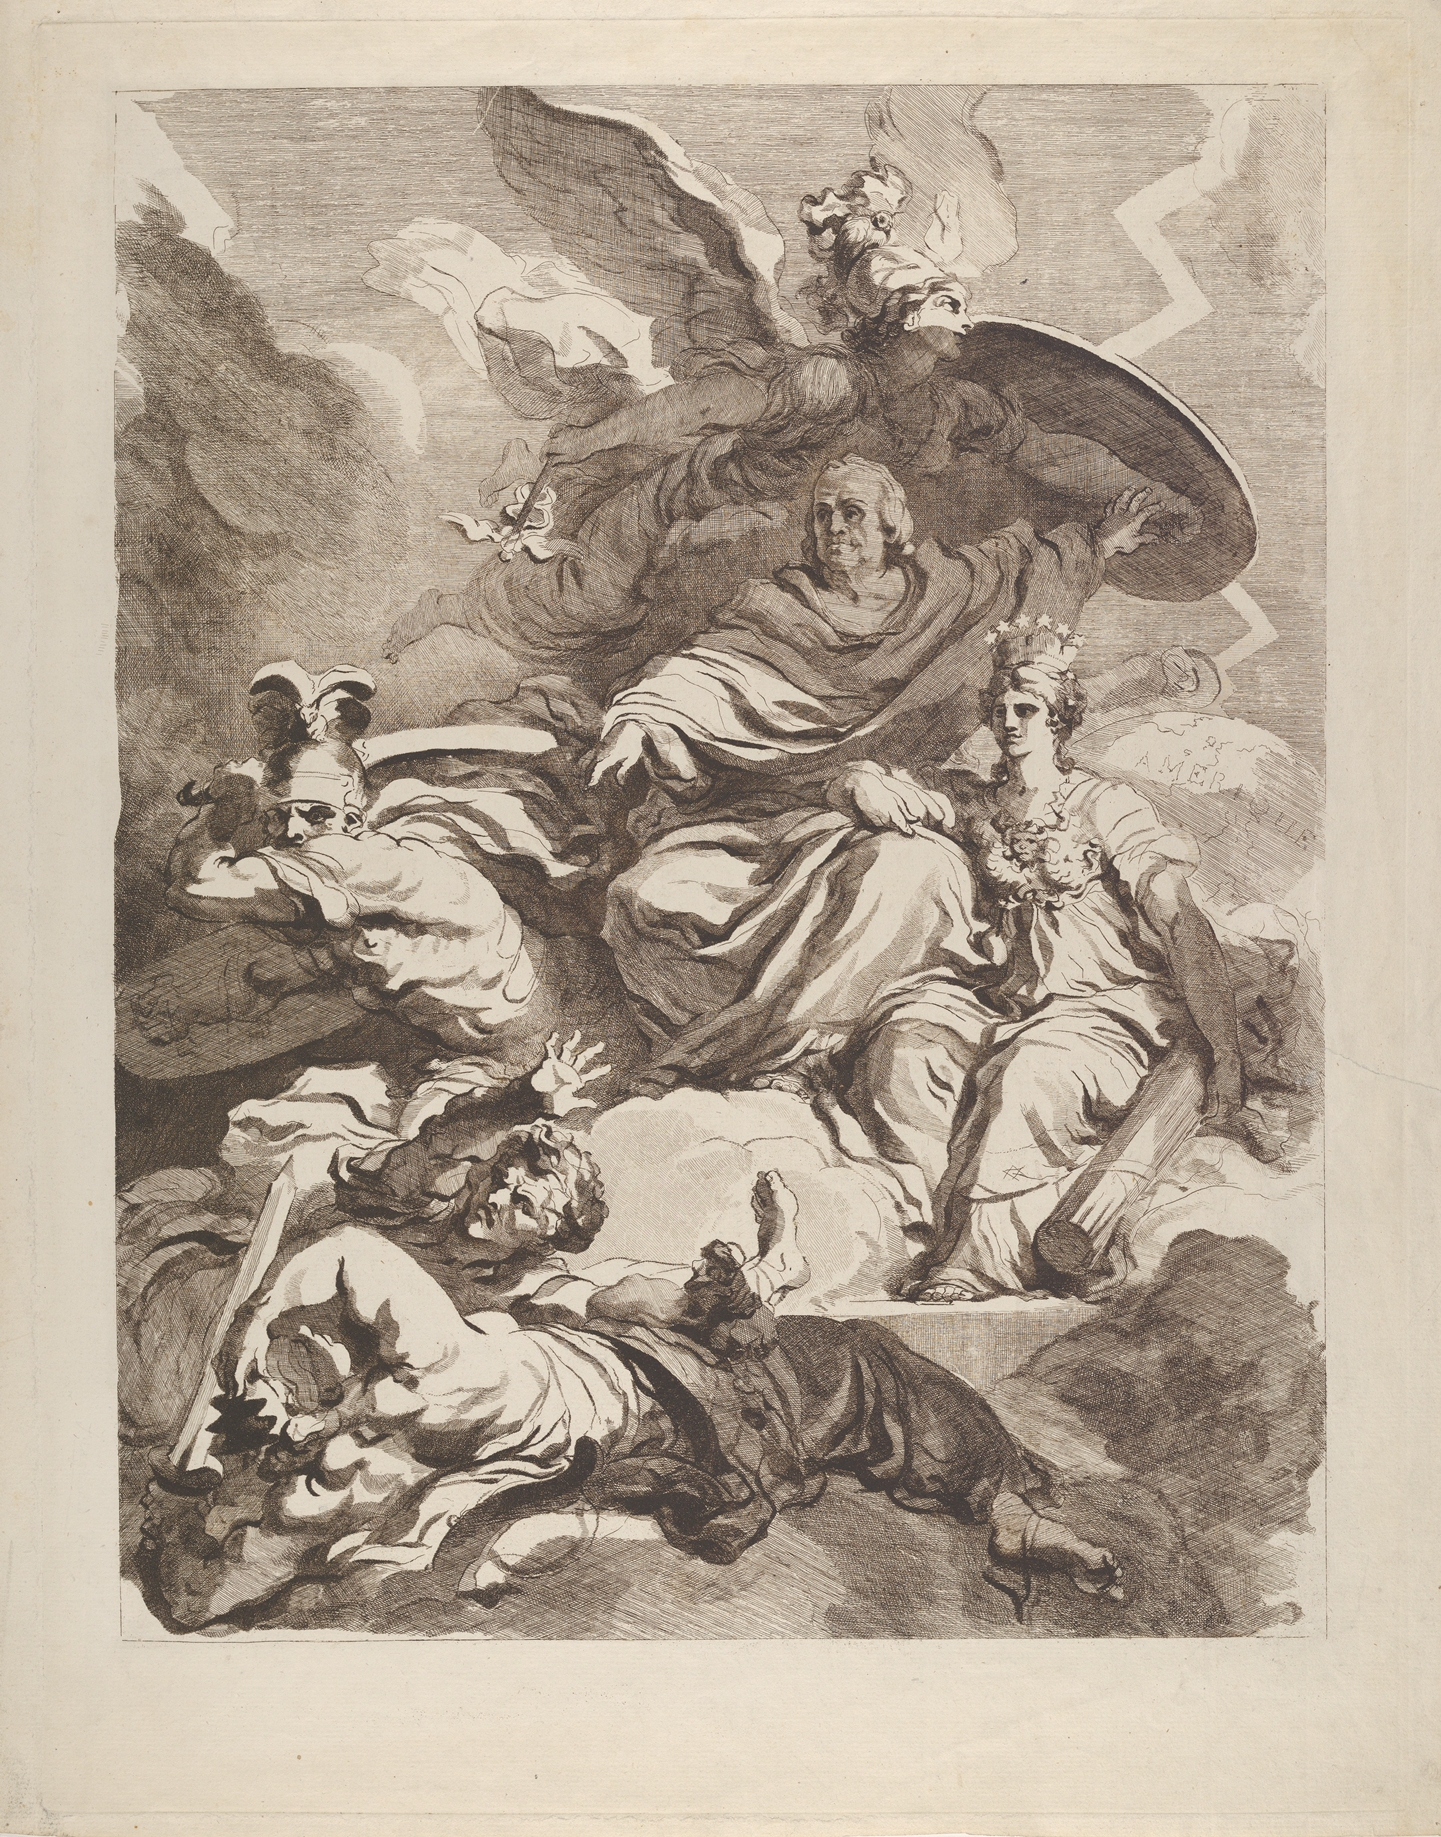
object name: print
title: To the Genius of Franklin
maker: marguerite gérard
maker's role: artist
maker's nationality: french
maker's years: 1761-1837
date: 1778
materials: ink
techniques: etching, printing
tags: shields,benjamin franklin,men,mars,minerva